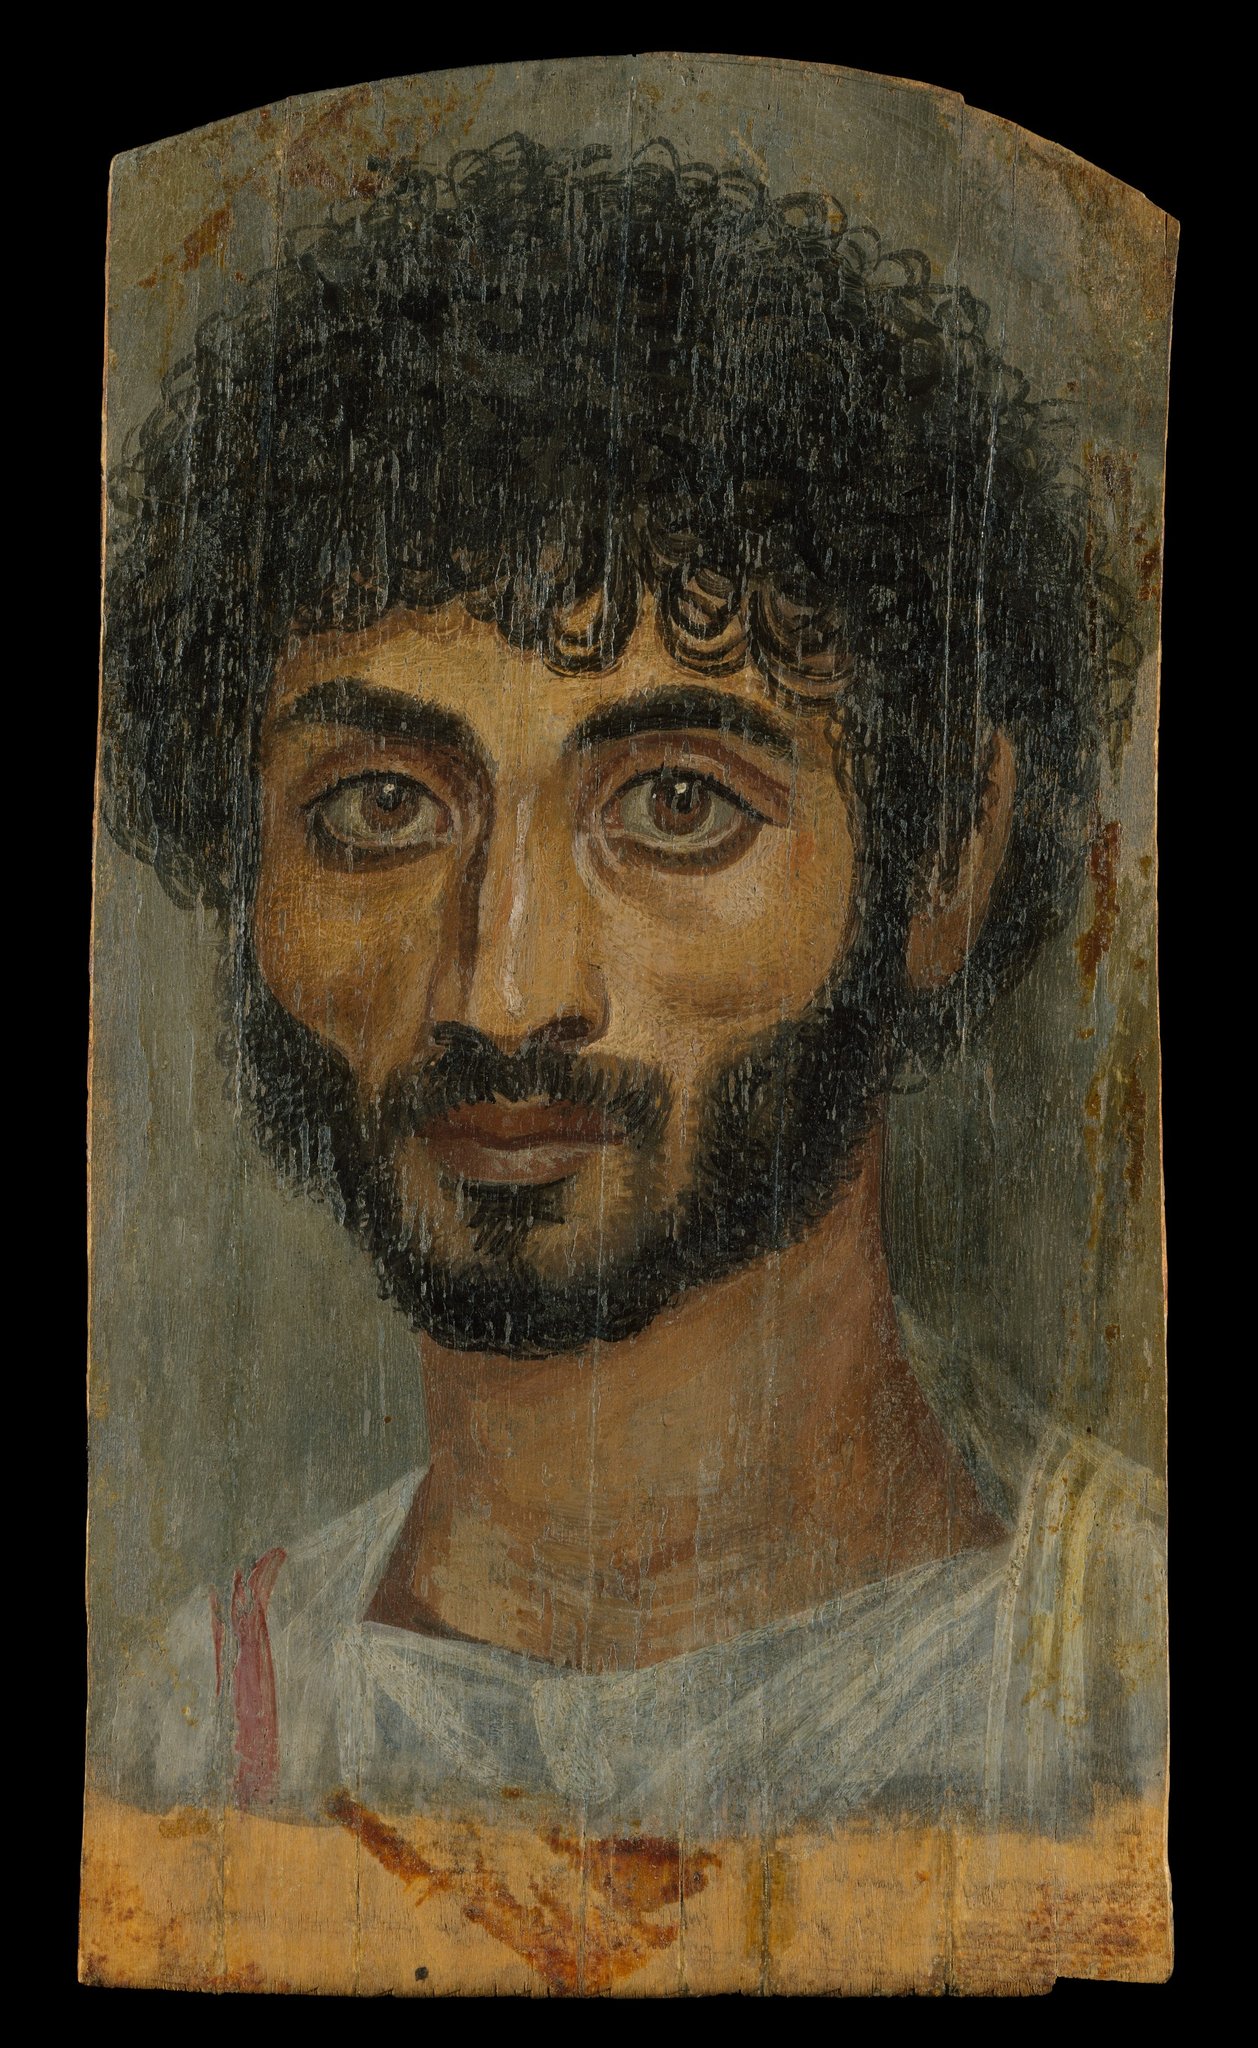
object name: panel painting, thin faced, bearded man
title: Portrait of a thin-faced, bearded man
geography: egypt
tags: men,portraits